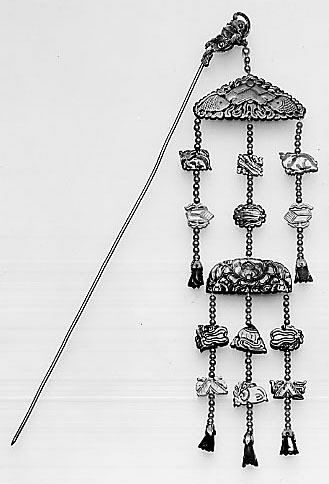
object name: hairpin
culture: chinese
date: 1701-1800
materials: amber, feather, metal, pearl